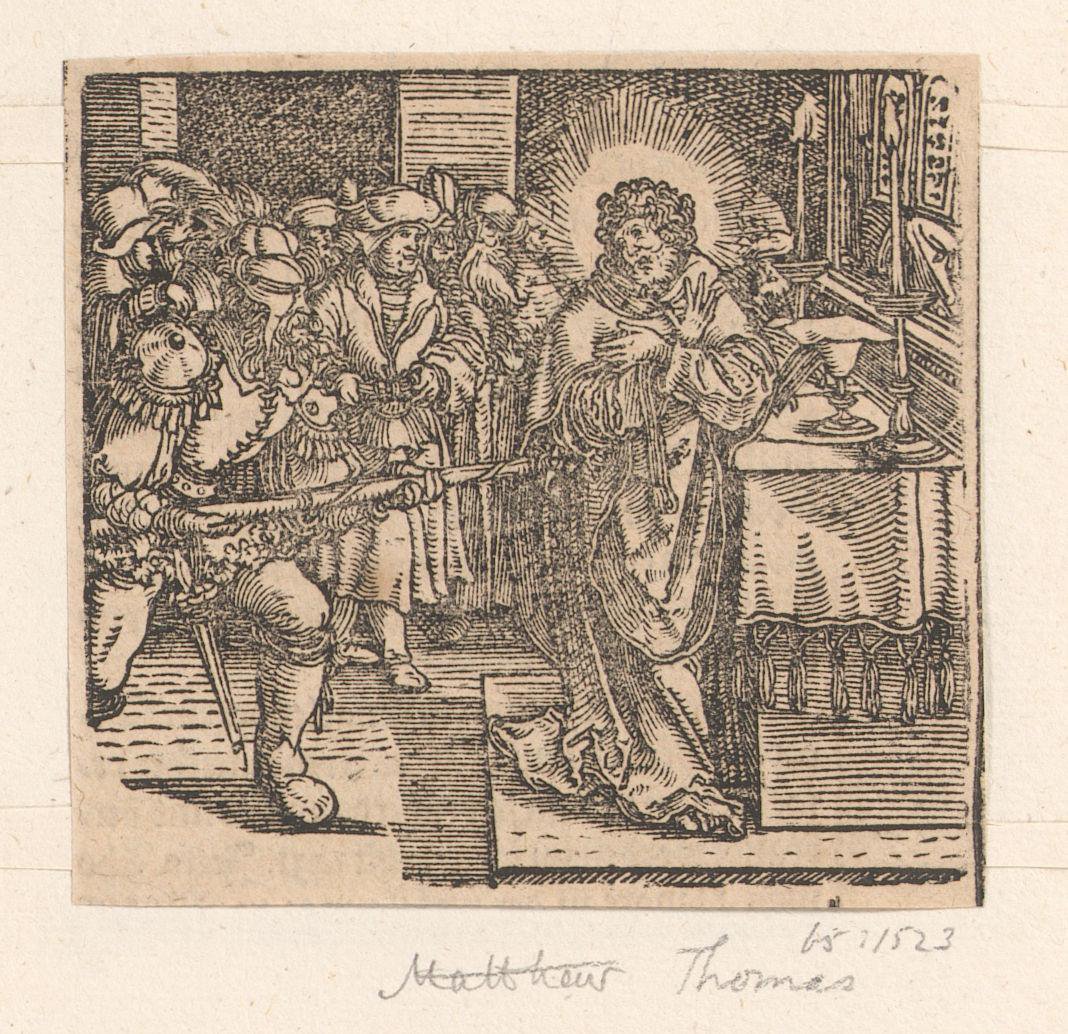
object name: print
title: Martelaarschap van Tomas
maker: Anonymous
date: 1500-1536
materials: paper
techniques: woodcut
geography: germany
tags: martyrdom and death of thomas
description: Tomas wordt terwijl hij bij een altaar staat met een speer doorstoken. Prent maakt deel uit van een album.